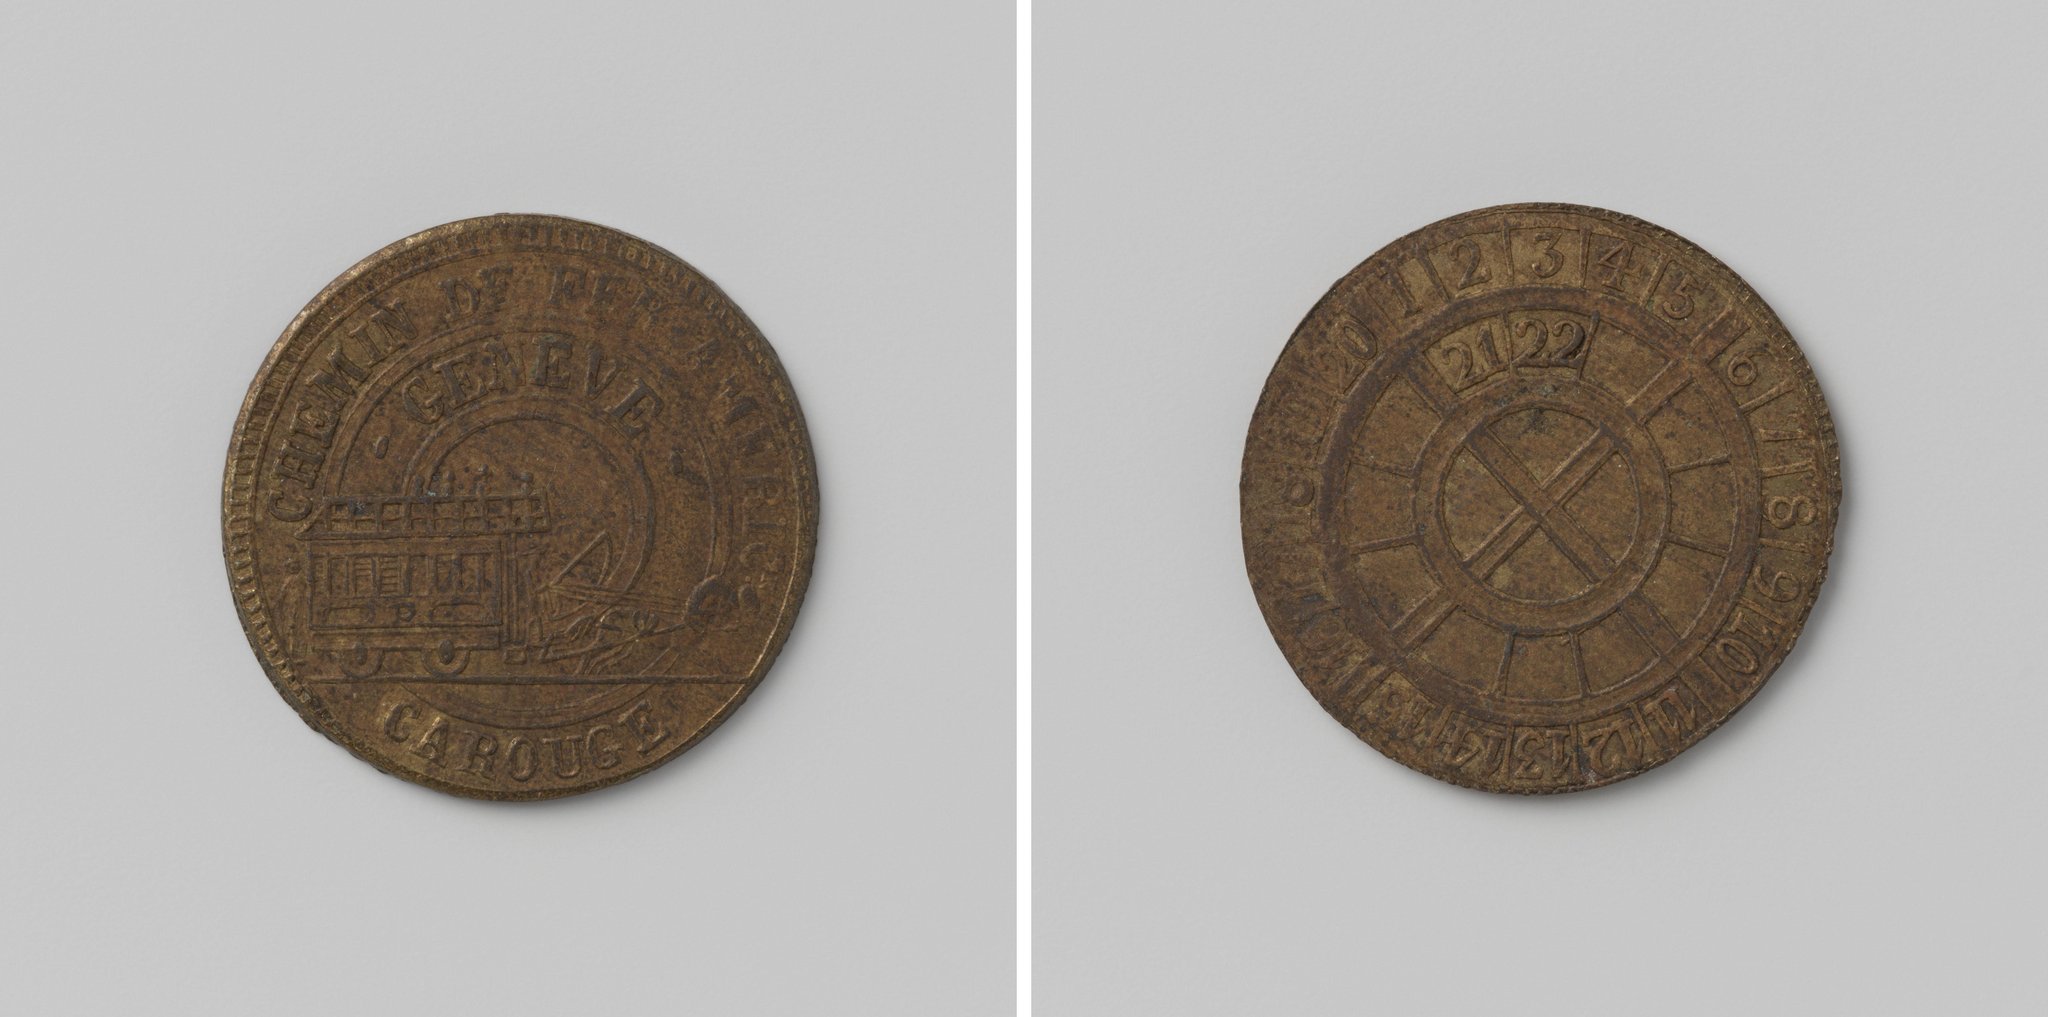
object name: adrespenning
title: Chemin de Fer Americain Geneve-Carouge (tramlijn Geneve-Carouge)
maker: Anonymous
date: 1862-1880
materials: brass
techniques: striking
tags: genève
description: Messing penning. Voorzijde: naar rechts rijdende locomotief binnen omschrift. Keerzijde: drie concentrische, cirkelvormige banen, verdeeld in resp. vier, twaalf en twintig compartimentjes; compartiemente van buitenste cirkel en twee compartimenten van middelste cirkel gevuld met cijfers oplopend van 1 tot 22